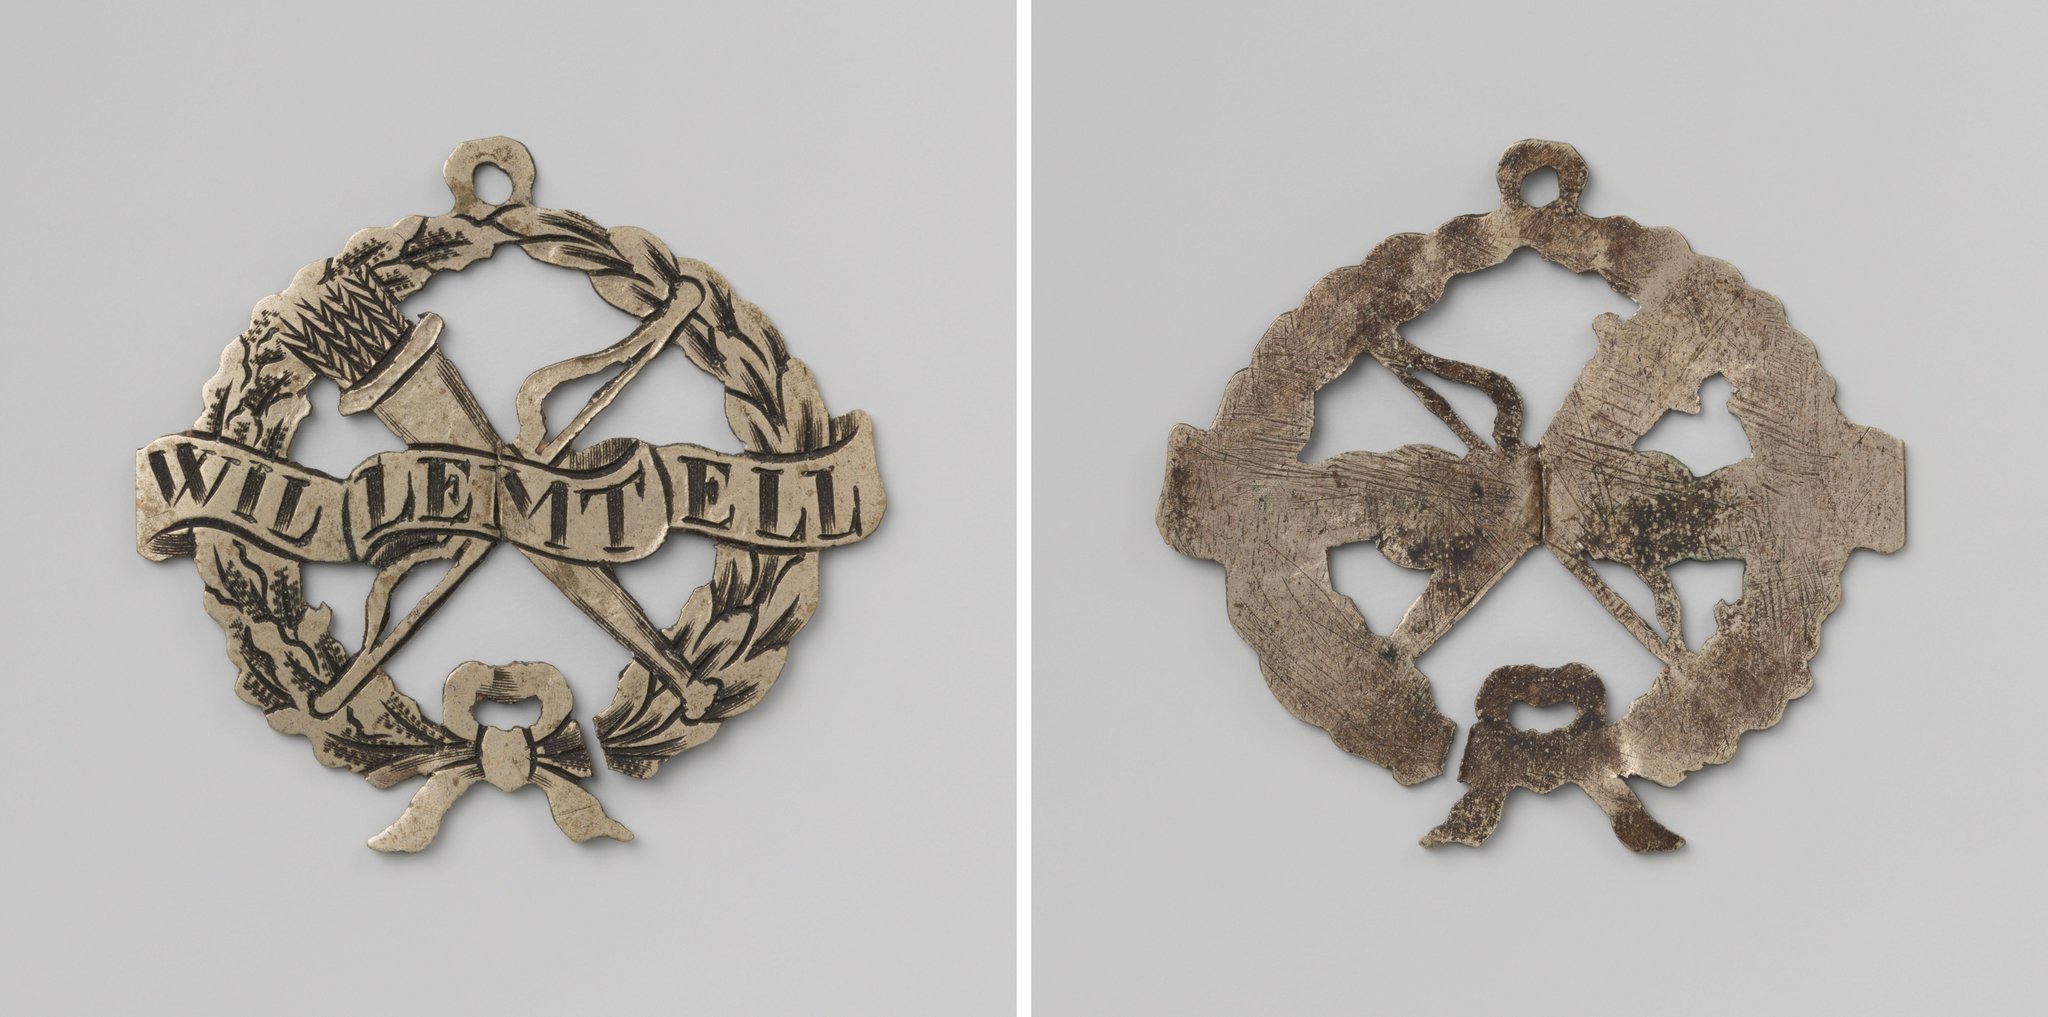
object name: medal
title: Handboogschutterij 'Willem Tell' te Rotterdam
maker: Anonymous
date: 1800-1875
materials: silver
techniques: engraving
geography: rotterdam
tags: rotterdam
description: Eenzijdig zilveren opengewerkt insigne aan draagoog, in vorm van gekruiste boog en pijlenkoker, waarover lint met opschrift is gedrapeerd binnen lauwerkrans